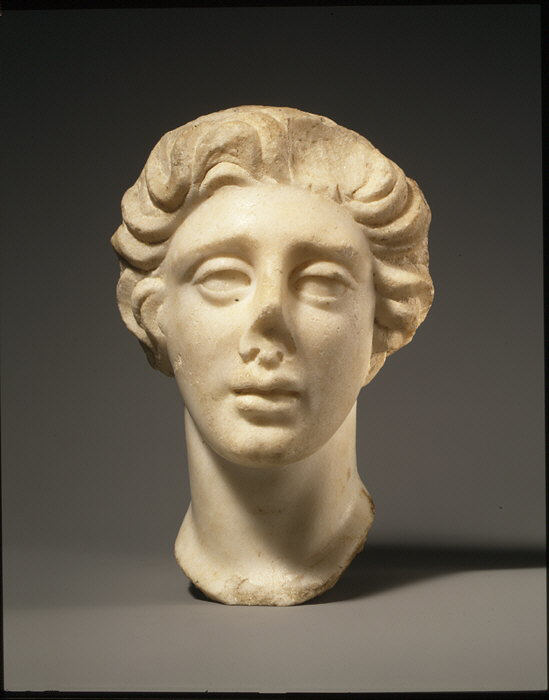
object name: head of a man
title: Marble head of a man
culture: greek, south italian, tarentine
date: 300-201 BCE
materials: marble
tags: heads,men